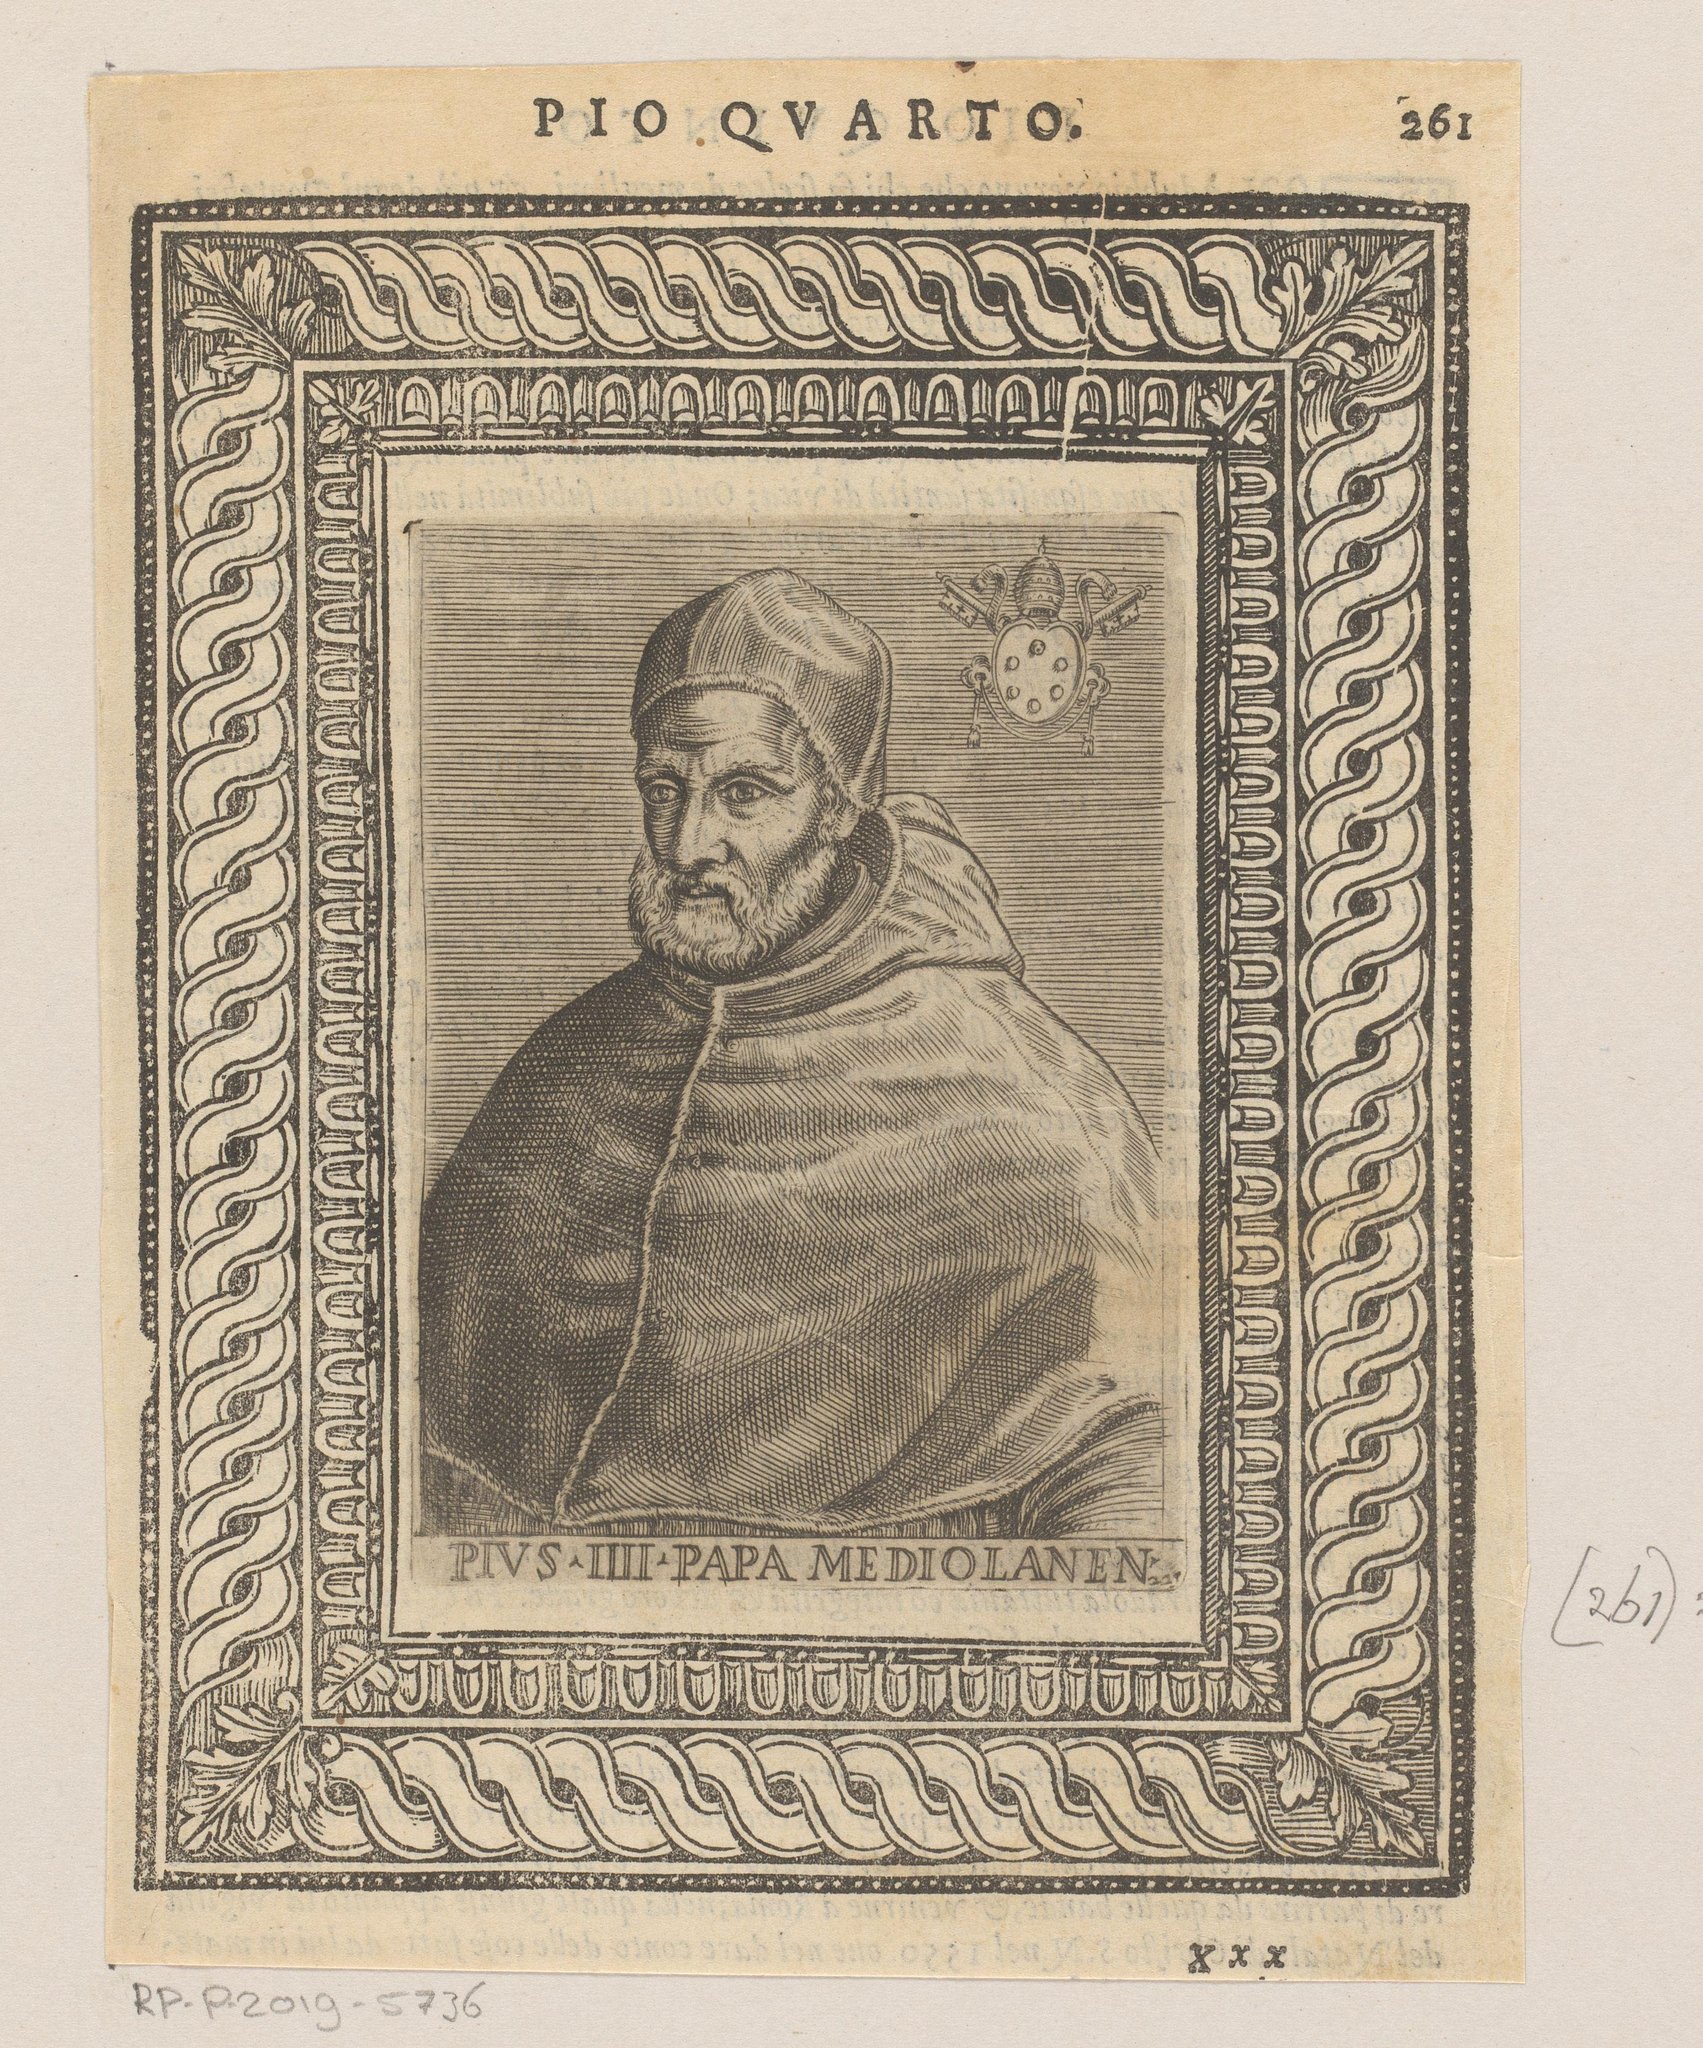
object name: book illustration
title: Pius IV Papa Mediolanen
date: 1587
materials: paper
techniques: engraving, letterpress printing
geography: rome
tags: pius iv, historical persons, pope, armorial bearing, heraldry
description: Prent uit: Ciccarelli, Antonio. Le vite de Pontefici di Antonio Ciccarelli (...). Rome: Domenico Basa, 1587. Prent voor het eerst verschenen in: Cavalieri, Giovanni Battista de'. Pontificum romanorum effigies (...). Rome: Domenico Basa en Francesco Zanetti, 1580. Prent ook gebruikt in latere publicaties.